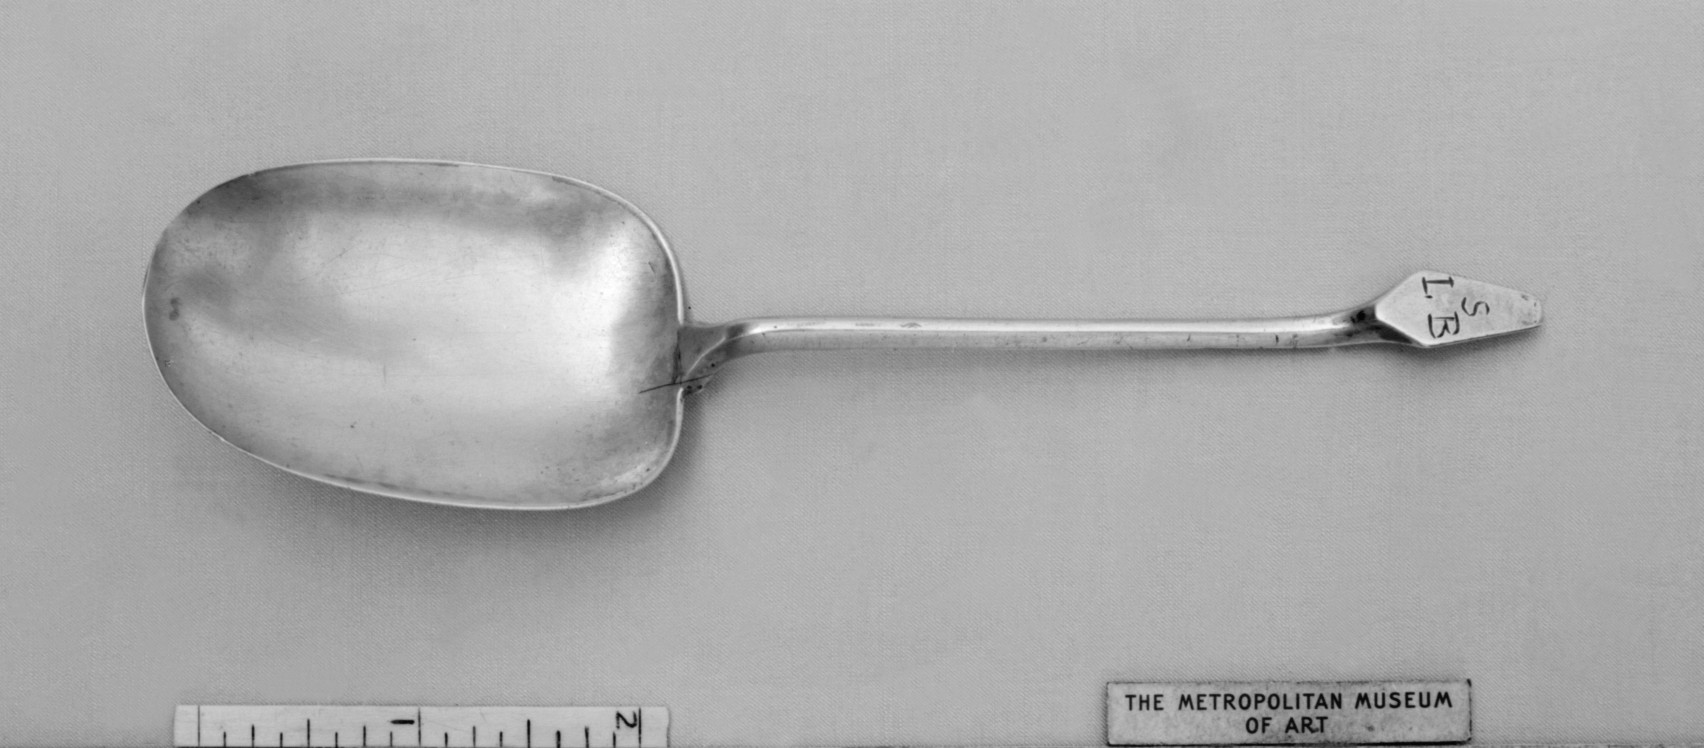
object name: spoon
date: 1701-1800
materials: silver